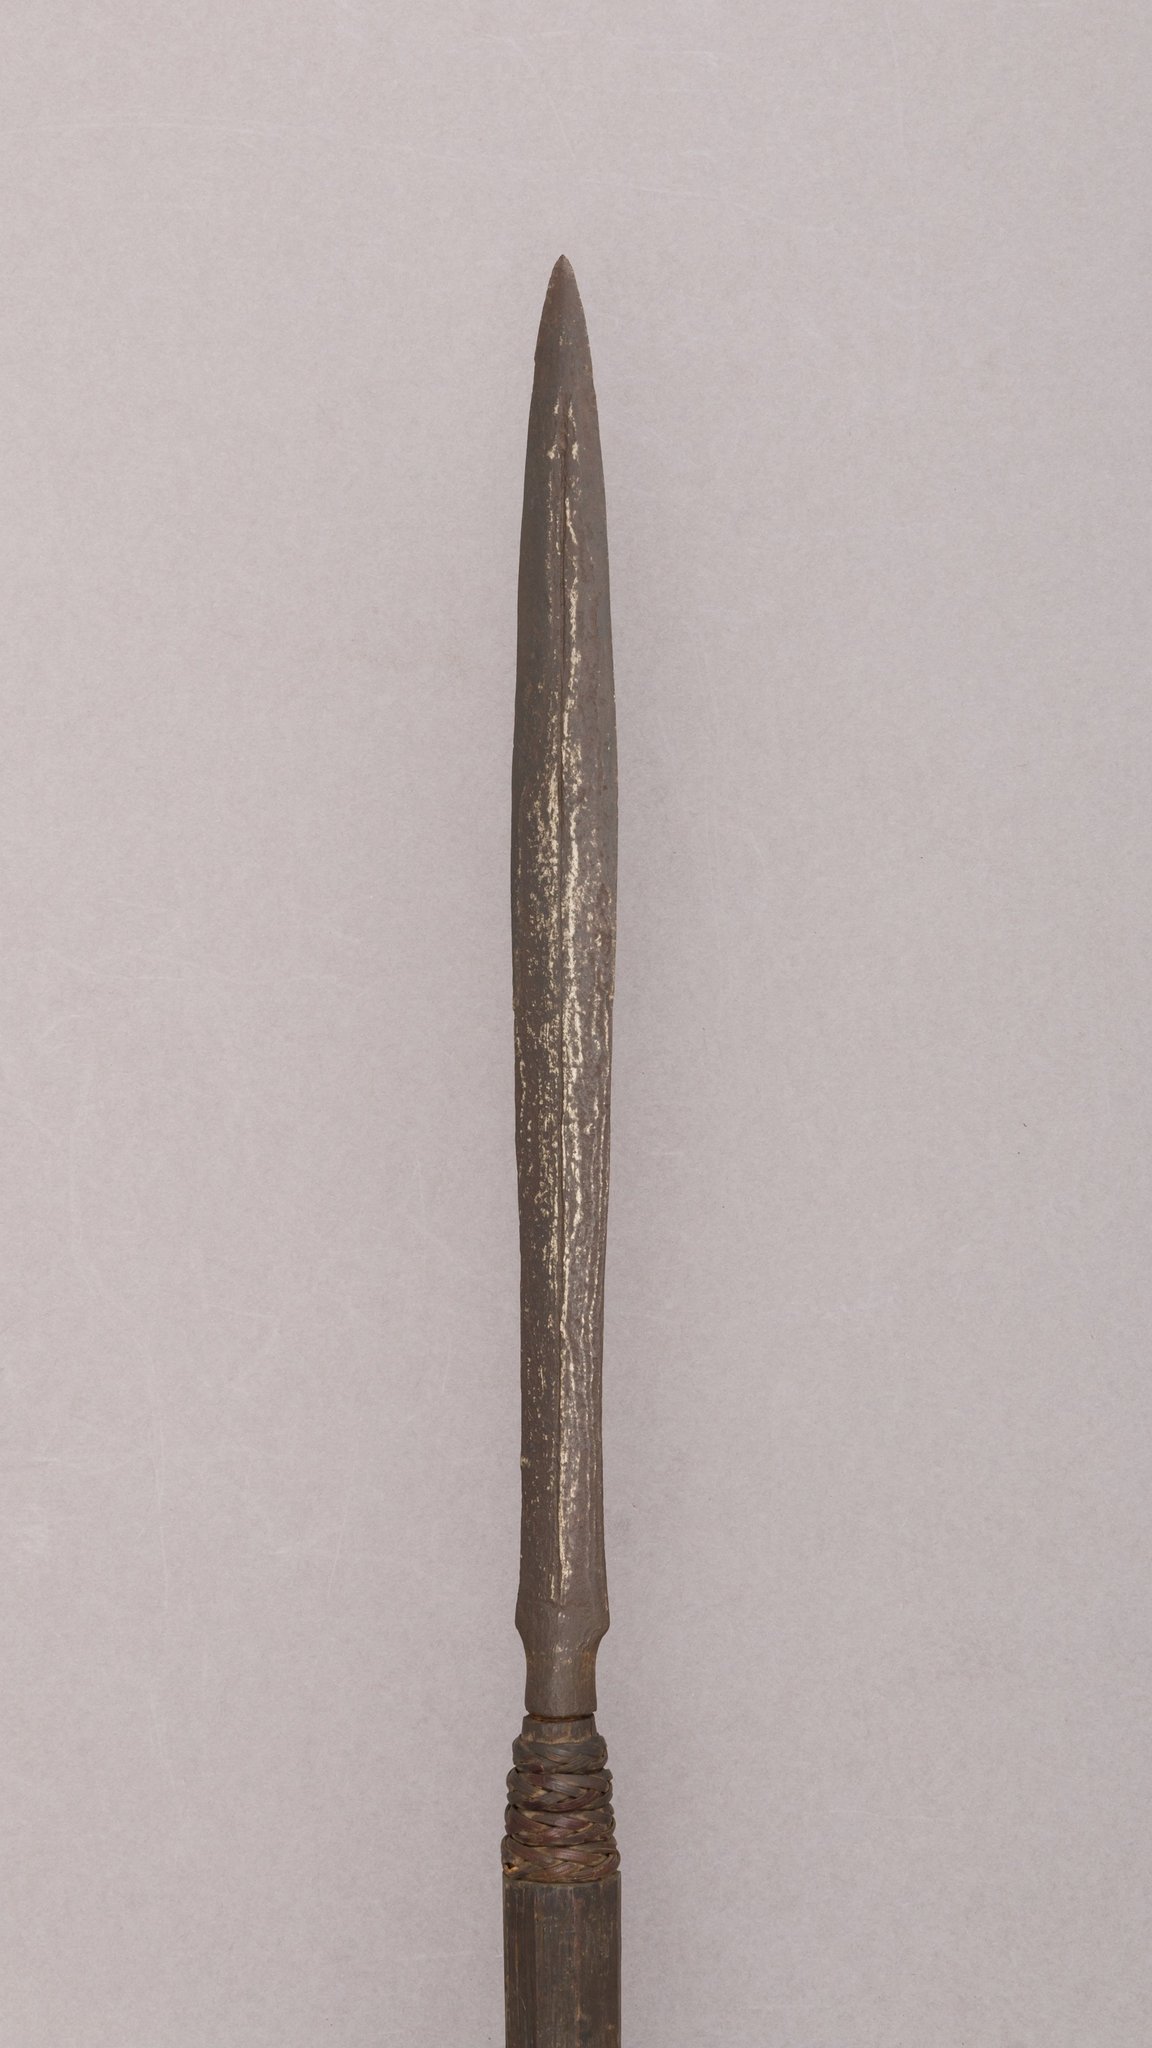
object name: spear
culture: malayan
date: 1701-1900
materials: wood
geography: malay archipelago